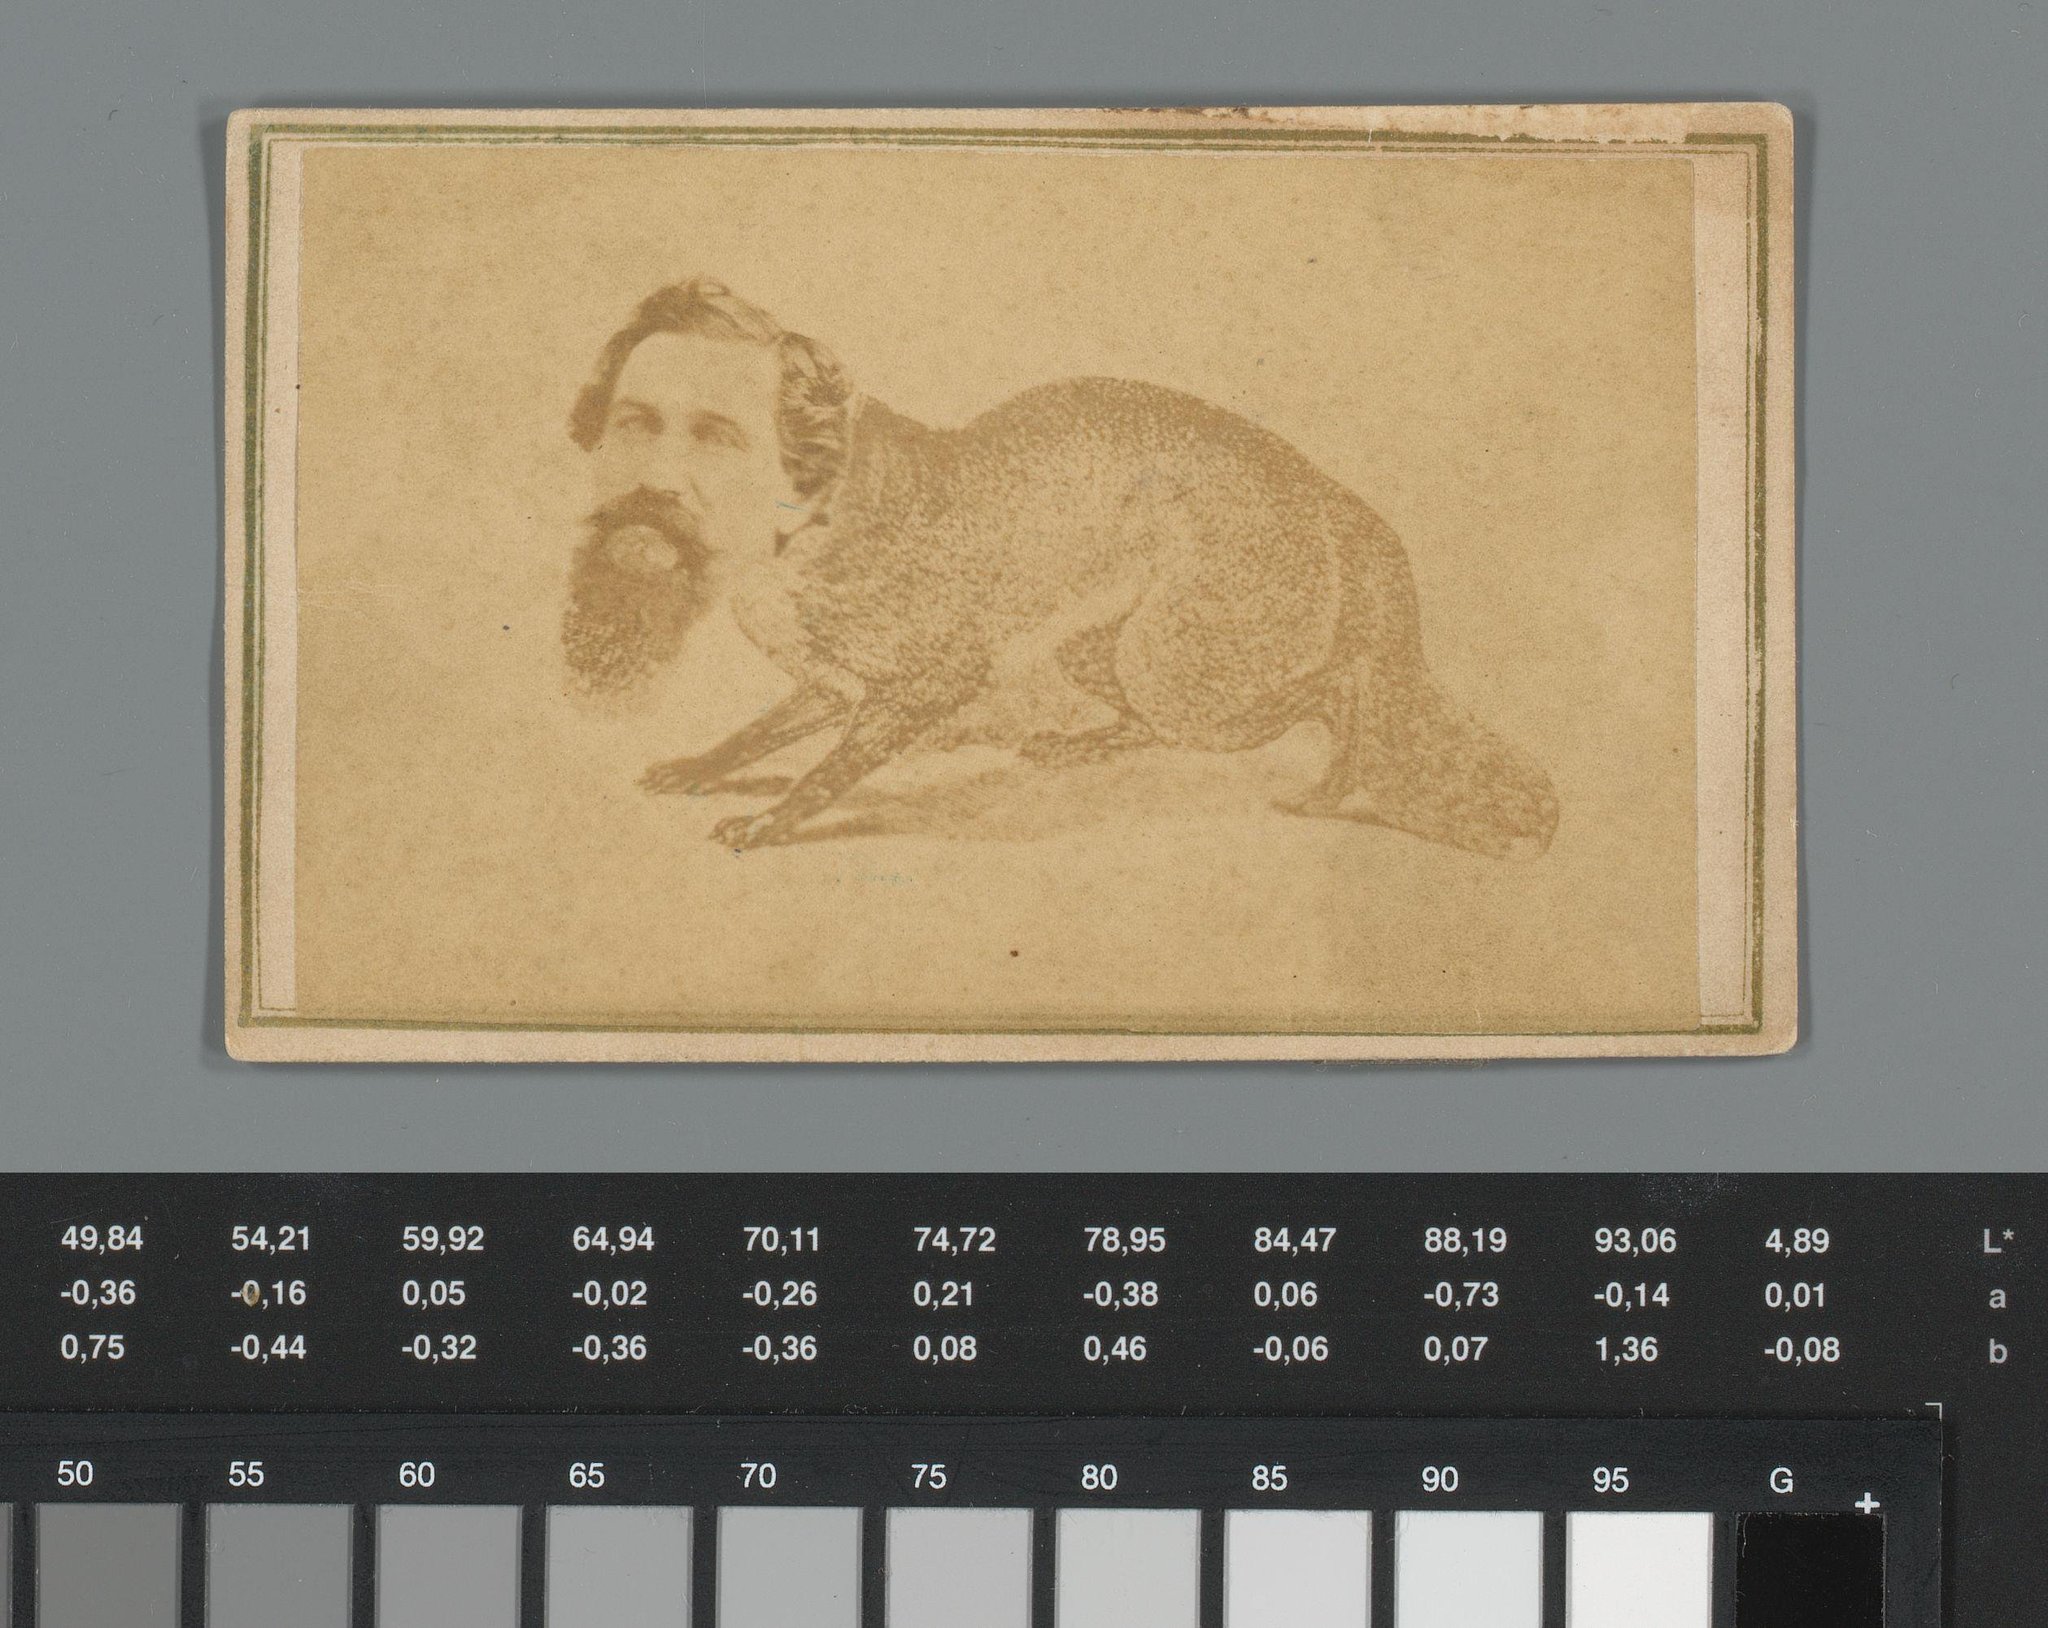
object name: carte de visite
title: Reclame voor de bakkerij van H. F. Fox in New York met fotoreproductie van een prent van een dier met mensenhoofd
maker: Anonymous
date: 1850-1915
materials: cardboard, photographic support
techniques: albumen print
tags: advertising, monsters of mixed human and animal shape; 'mostri' (ripa)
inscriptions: inscription: ‘(...)’